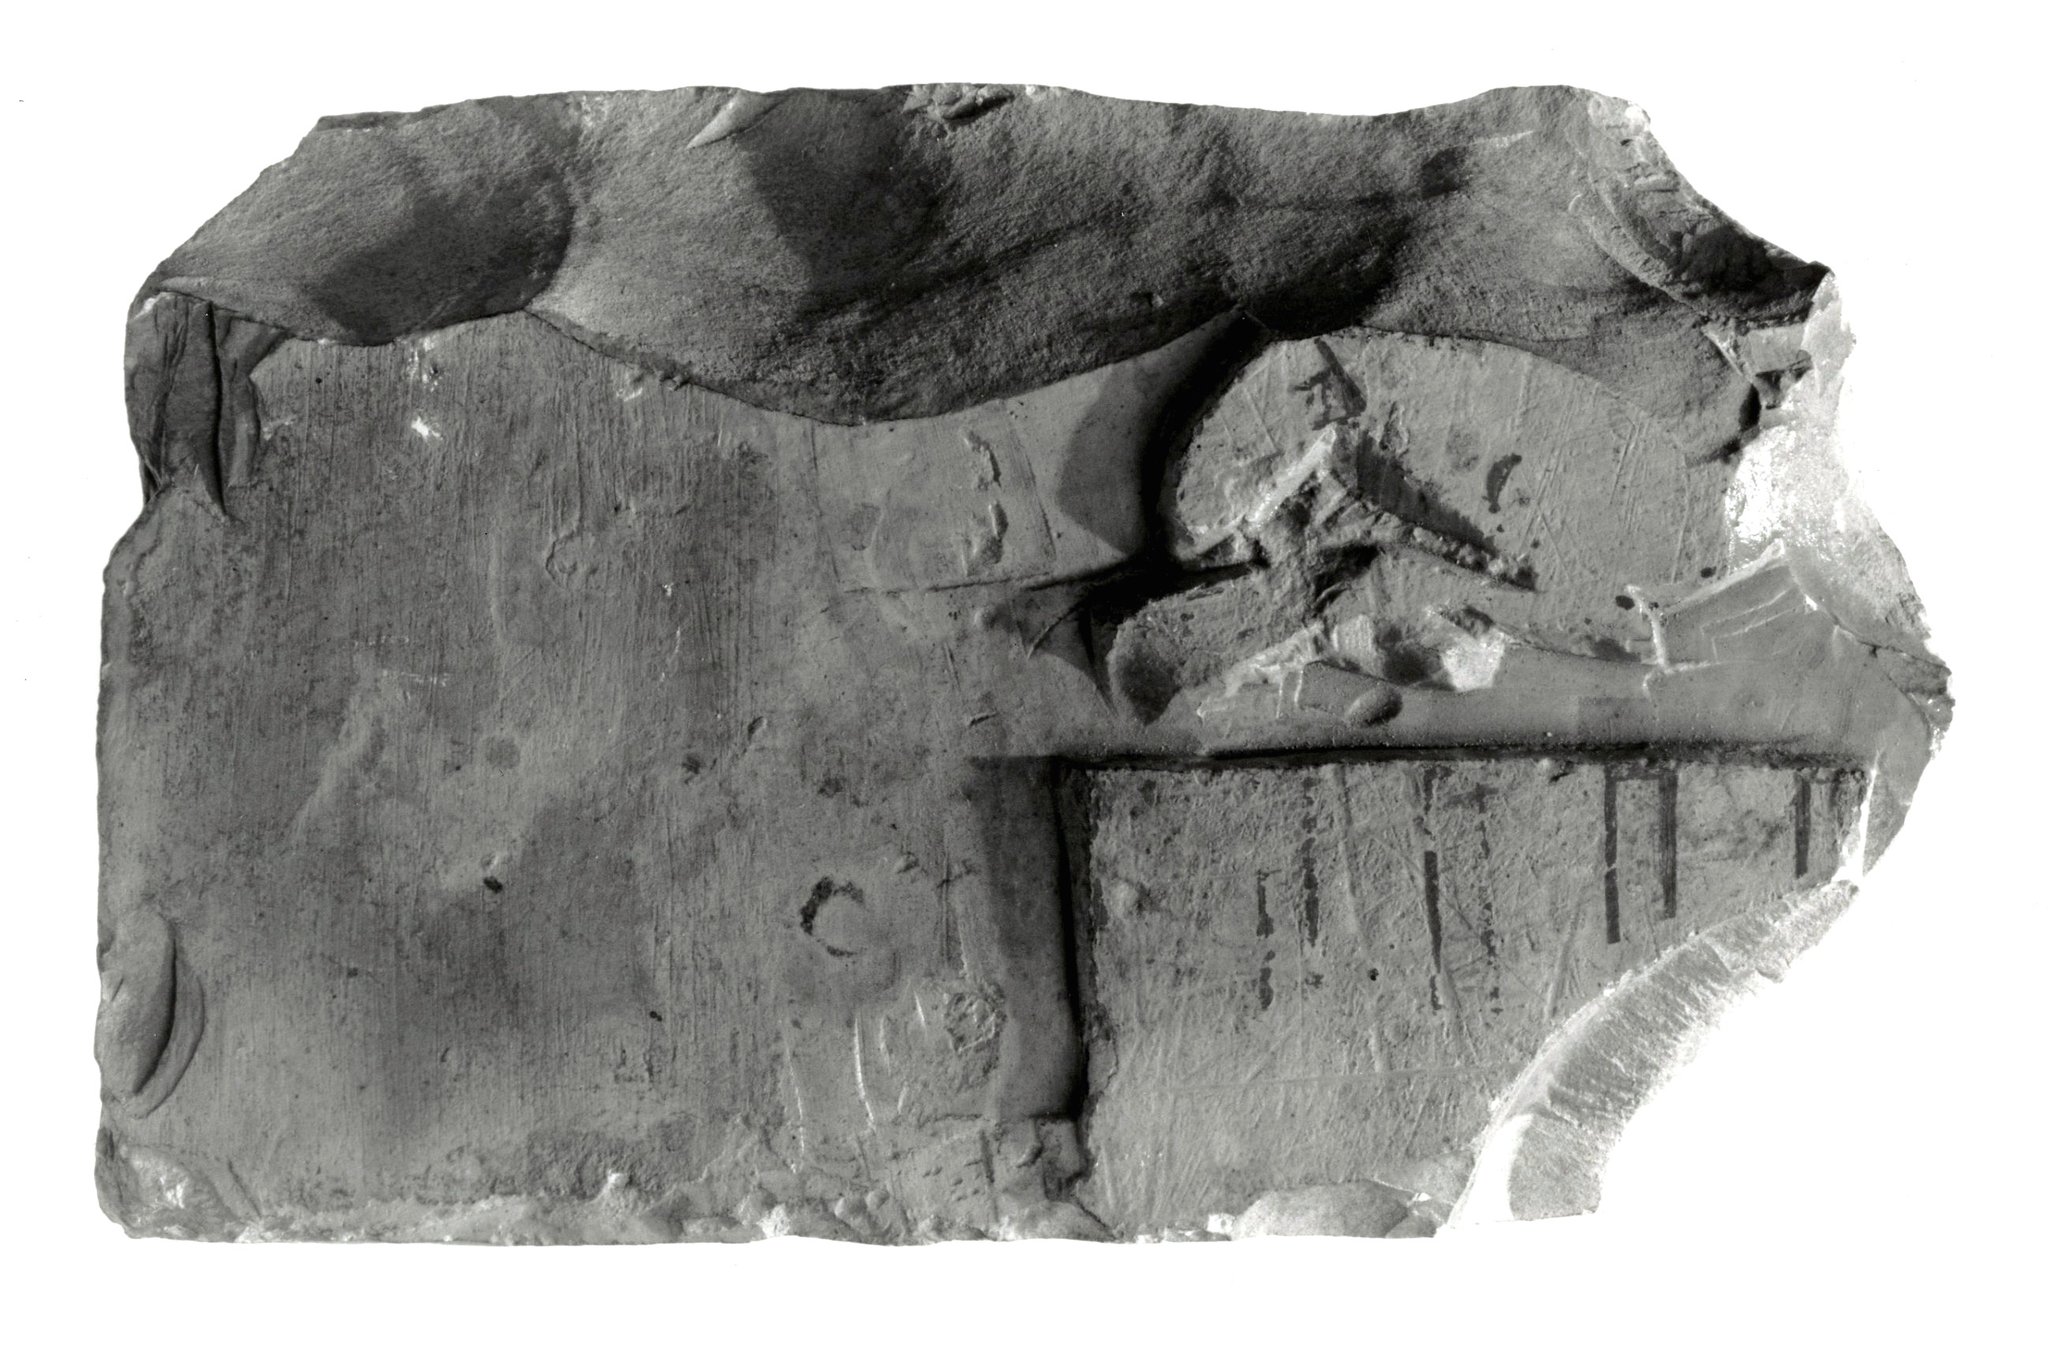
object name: relief, tomb of nespekashuty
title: Raised Relief Fragment with Preliminary Drawing of Offerings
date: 664-610 BCE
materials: limestone, varnish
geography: egypt